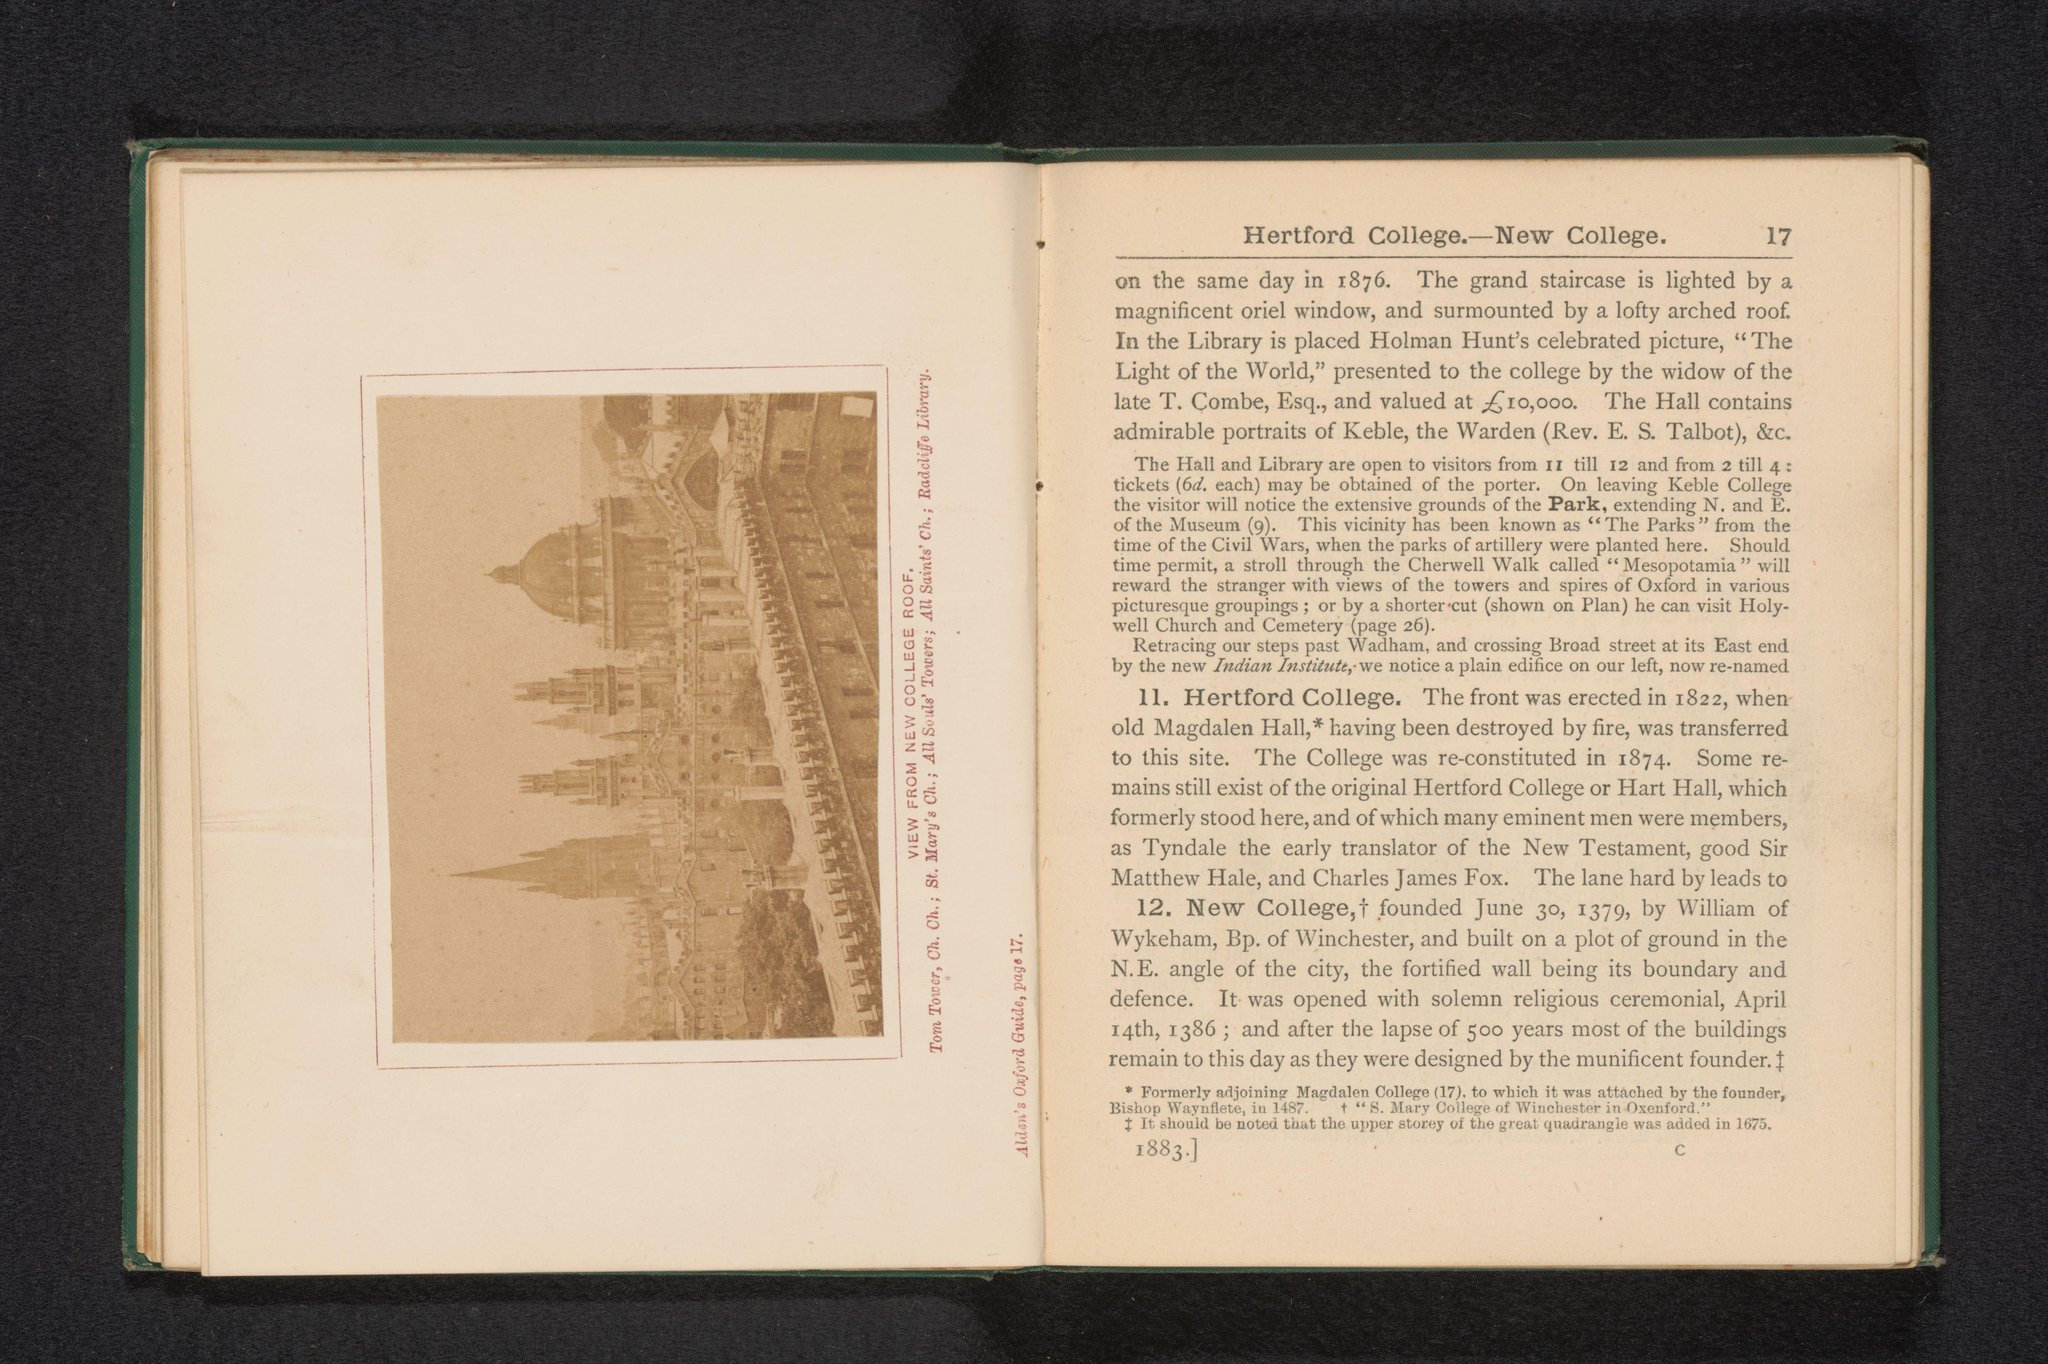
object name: page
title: View from new college roof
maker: Anonymous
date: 1878-1883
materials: photographic support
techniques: albumen print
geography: oxford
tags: city-view in general; 'veduta', church (exterior), parts of church exterior and annexes: tower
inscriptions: inscription: ‘Tom Tower, Ch. Ch; St. Mary's Ch. ; All Souls'Towers ;All Saints' Ch. ; Radcliffe Library’